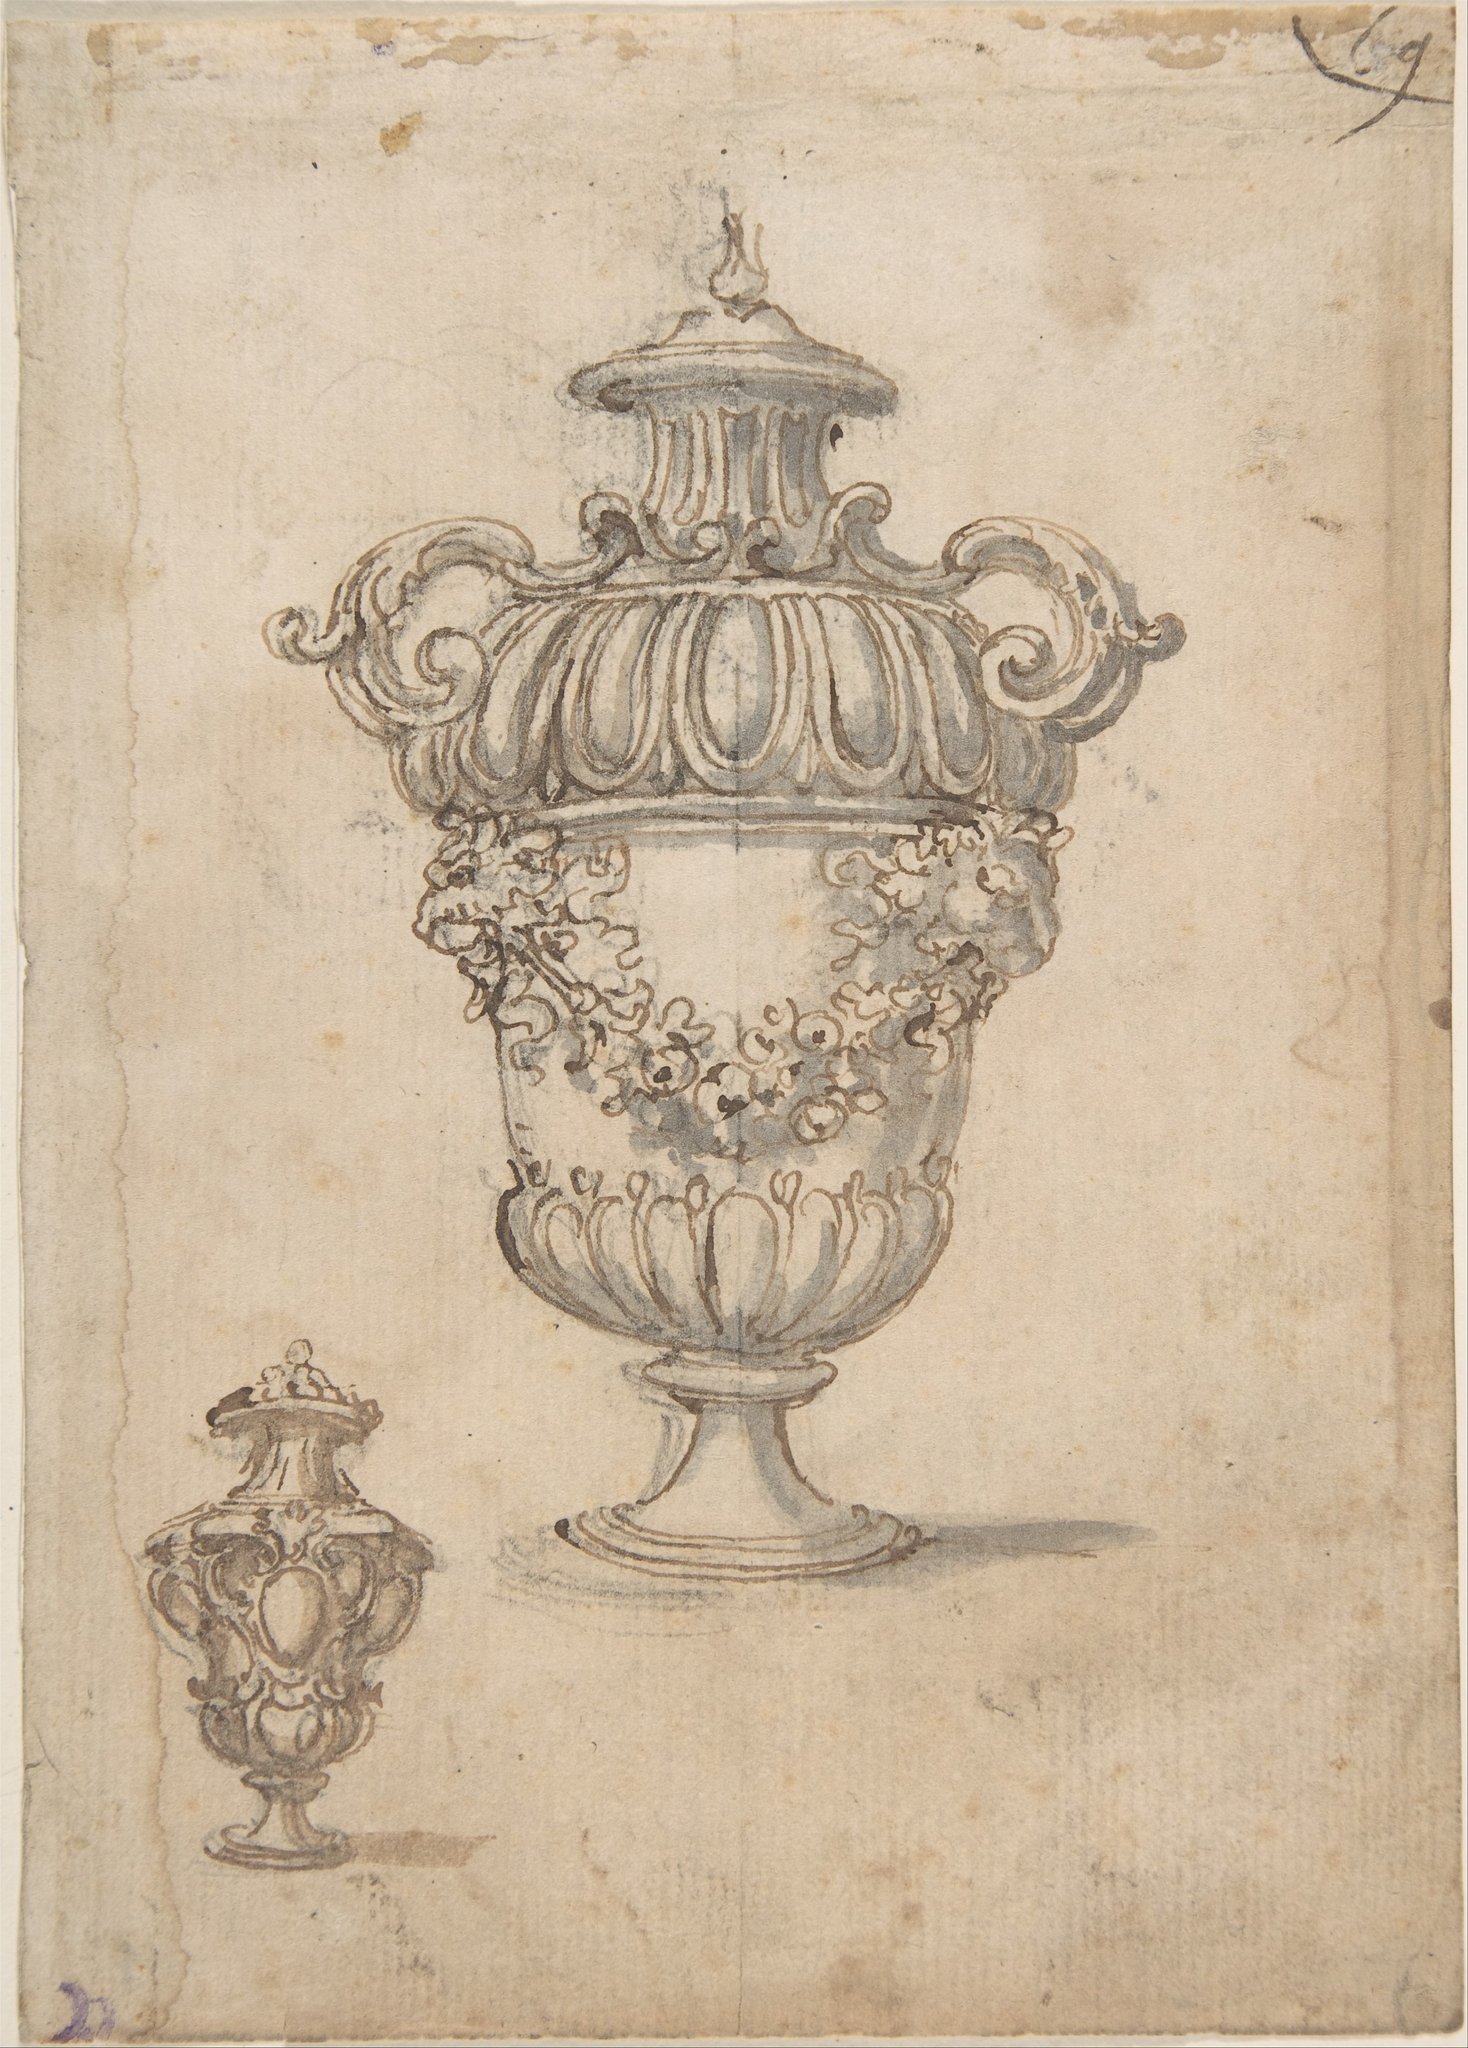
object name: drawing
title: Two Designs for Vases (recto); Design for Candle Stick (?) (verso)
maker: giovanni battista foggini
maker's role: artist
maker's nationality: italian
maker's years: 1652-1725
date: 1672-1725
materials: chalk, graphite, ink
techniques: brush, pen, wash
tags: candlesticks,vases